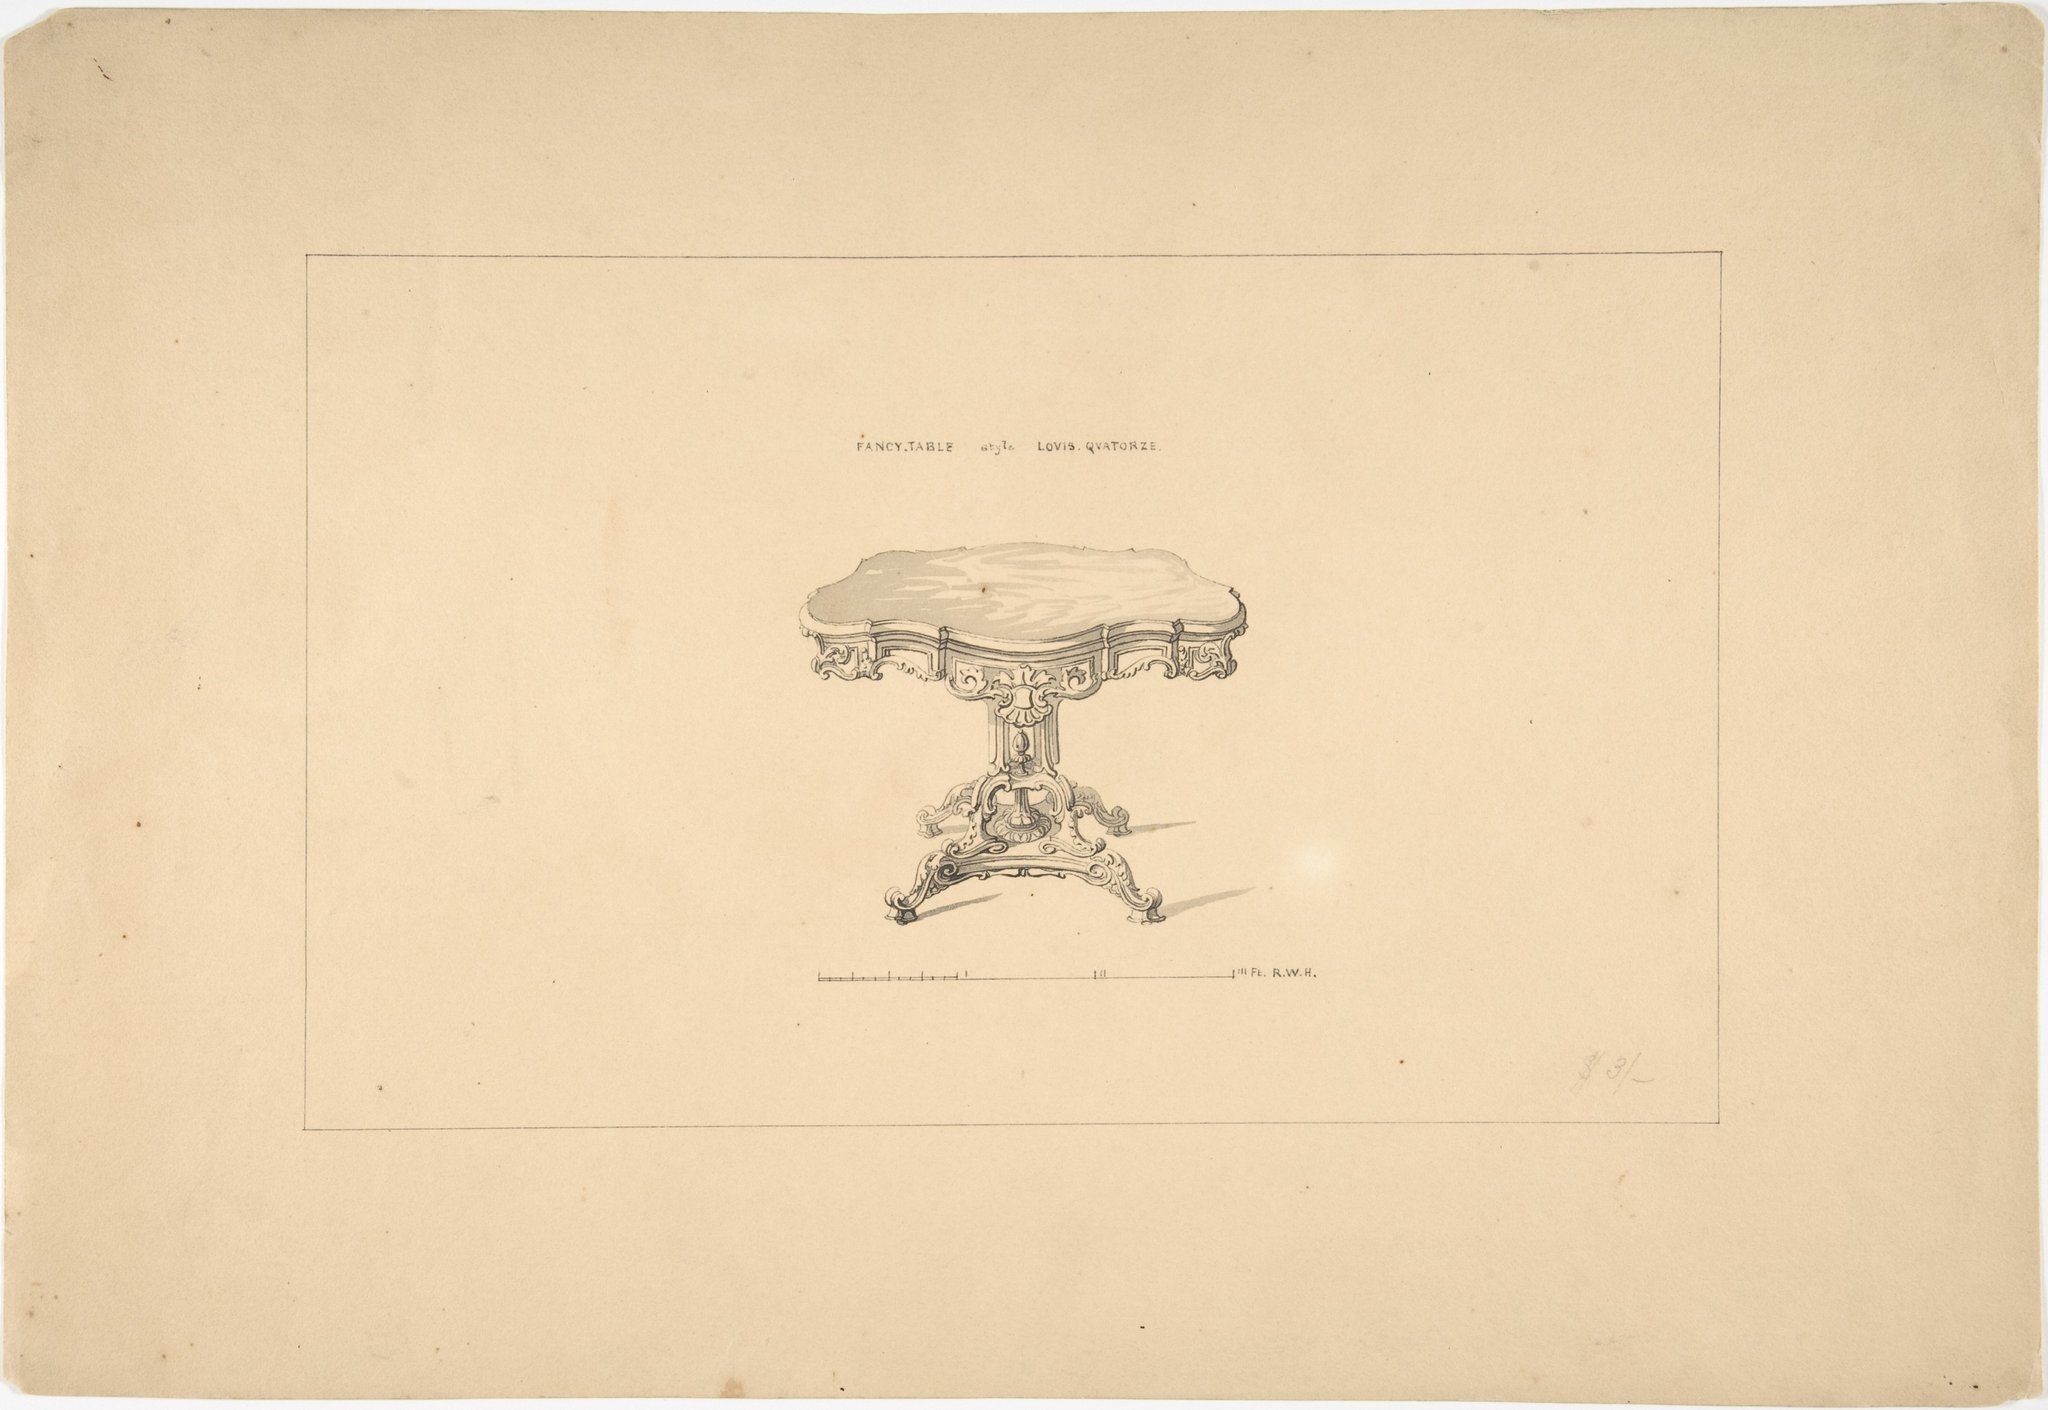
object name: drawing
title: Design for a Fancy Table, Louis Quatorze Style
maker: robert william hume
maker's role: artist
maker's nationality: british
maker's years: 1816-1904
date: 1835-1900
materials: graphite, ink, watercolor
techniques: pen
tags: tables